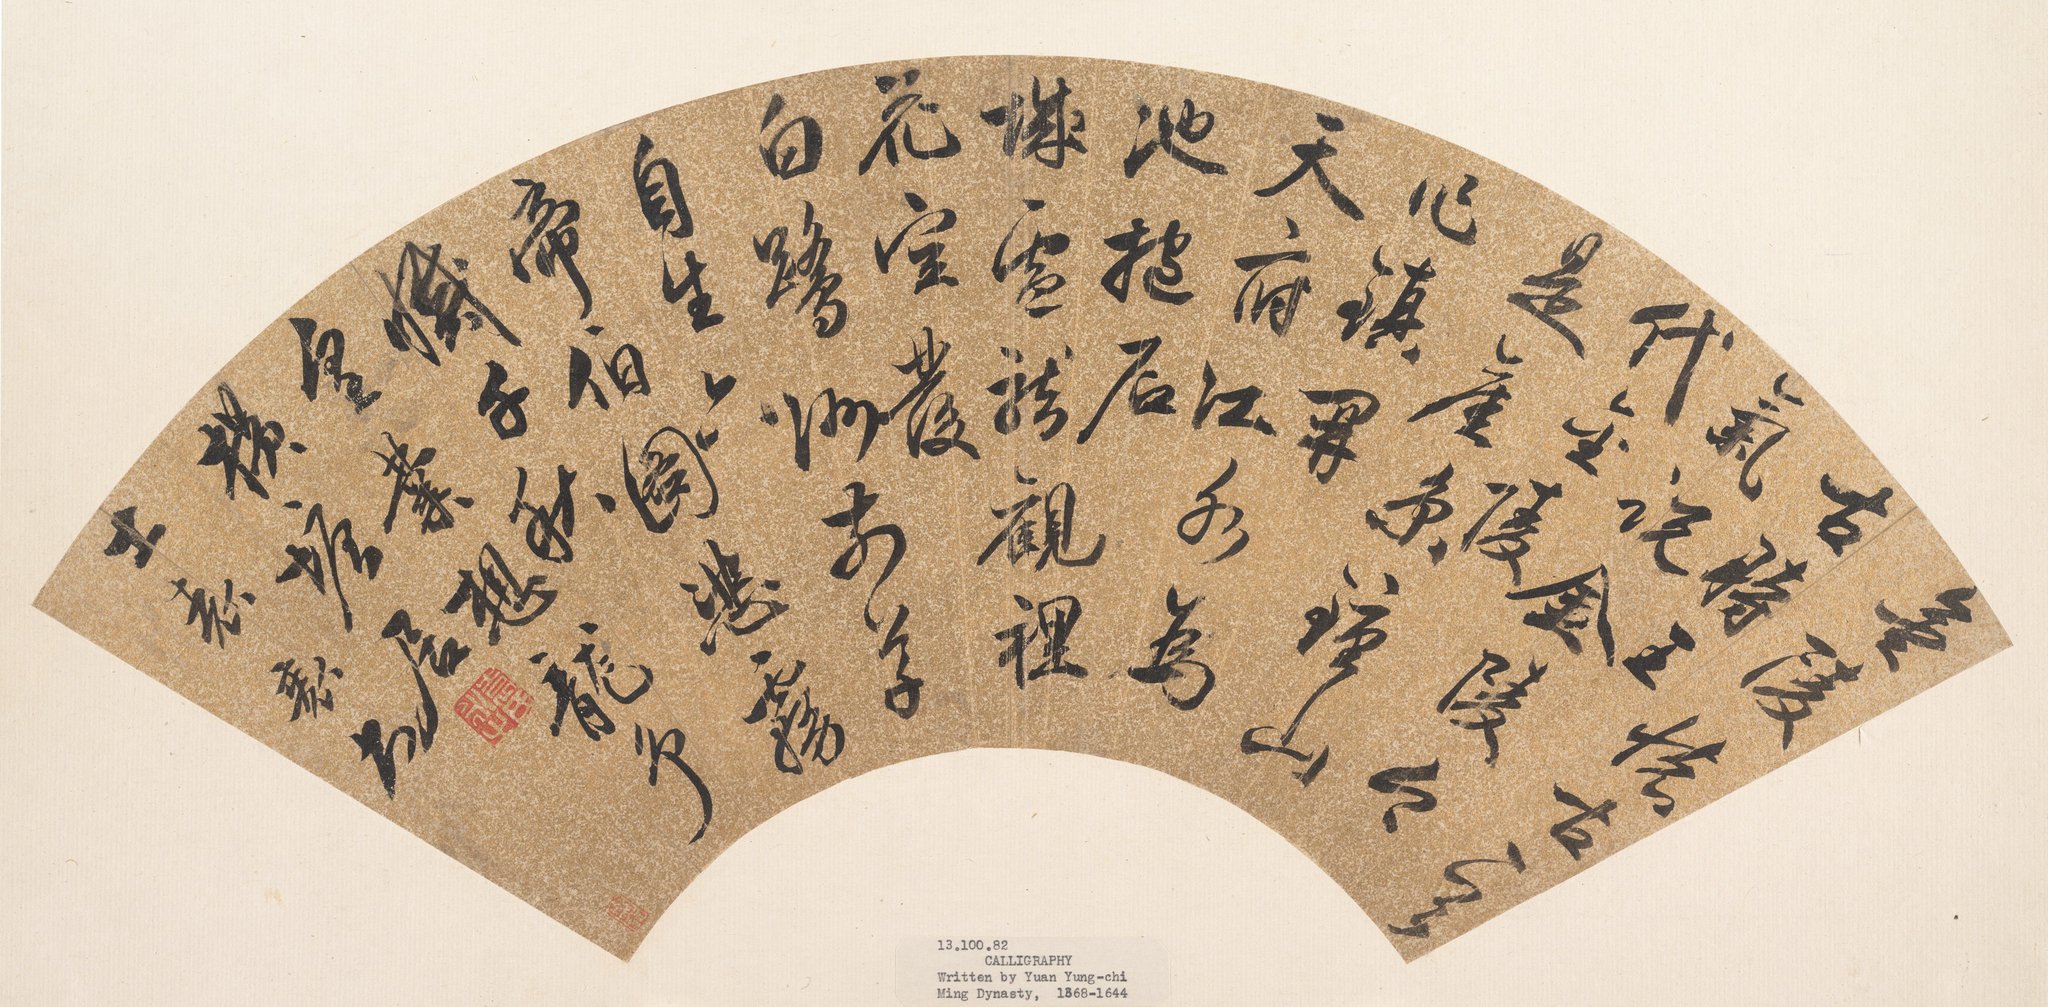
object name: folding fan mounted a an album leaf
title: Calligraphy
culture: chinese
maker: yuan zhi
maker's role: artist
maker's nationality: chinese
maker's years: 1502-1547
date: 1502-1547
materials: ink, paper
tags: calligraphy